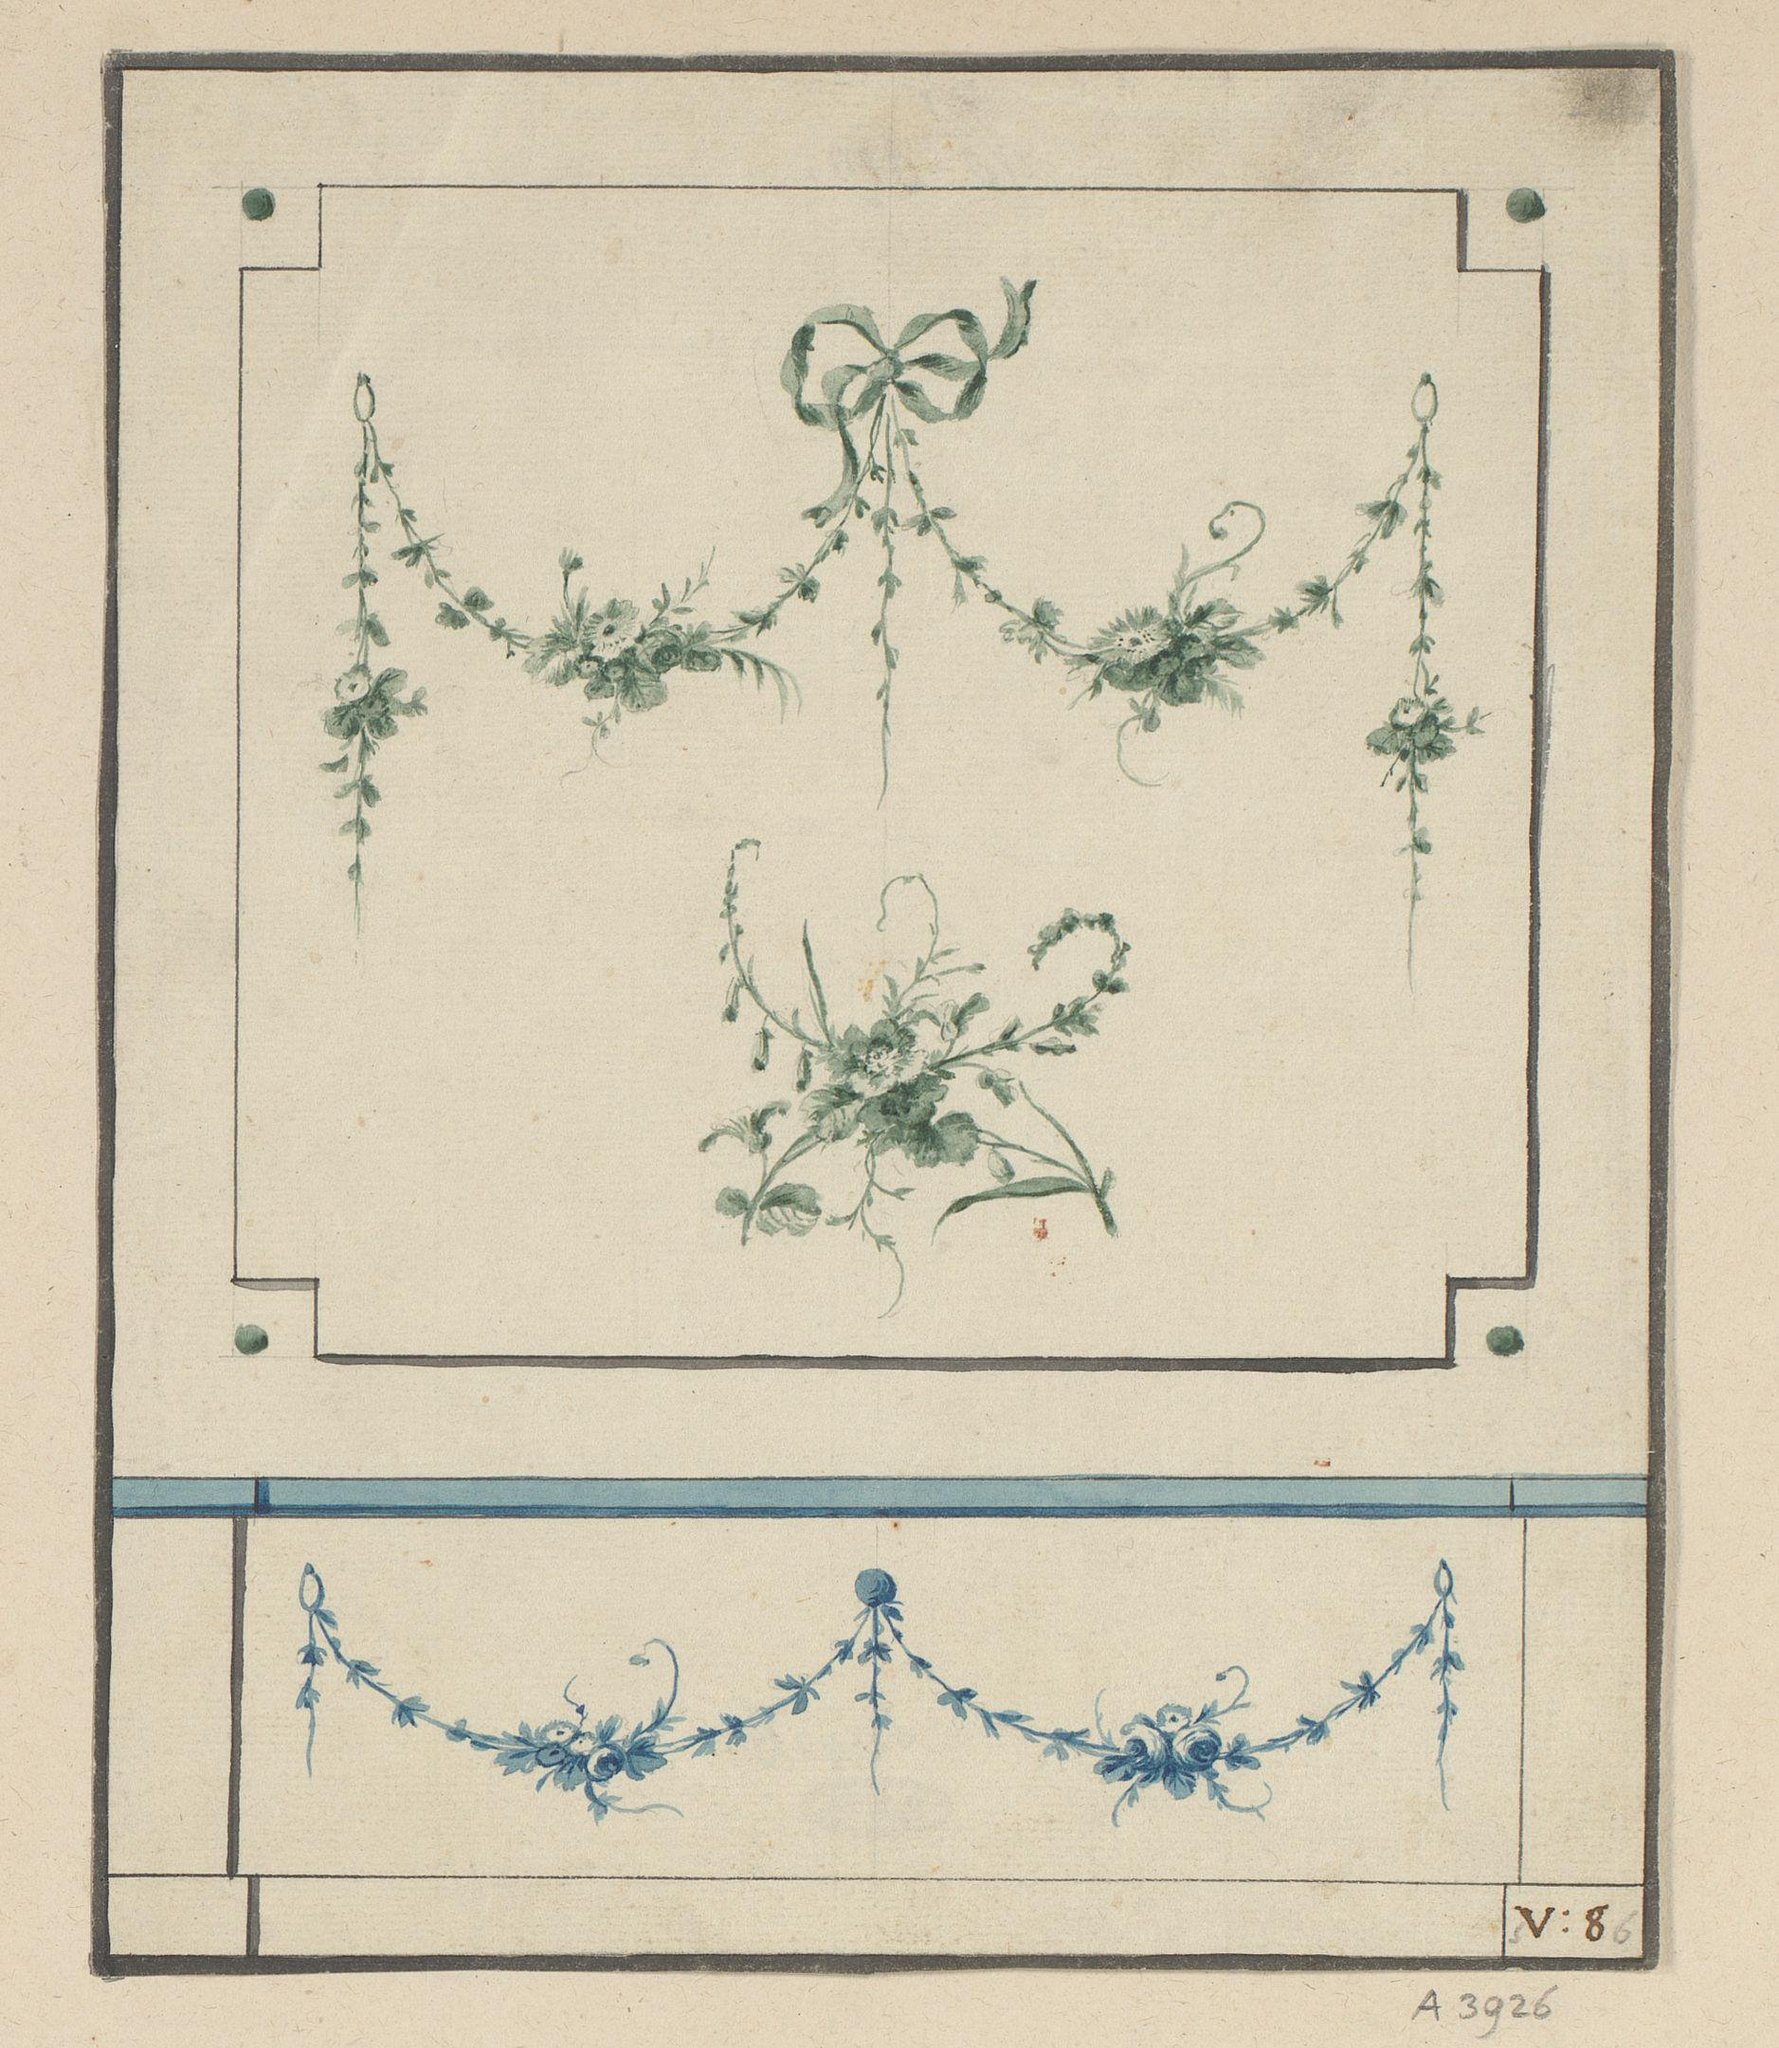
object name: album leaf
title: Ontwerptekening voor een kamerwand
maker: abraham van strij (i)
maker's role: draughtsman, painter, print maker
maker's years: 1753-1826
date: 1763-1826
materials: paint, paper, pencil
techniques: brush, pen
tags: garland, wreath, wall-covering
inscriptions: collector's mark: Lugt 2228, inscription: ‘No. 619.’, inscription: ‘V: 8’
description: De tekeningen van Abraham van Strij zijn op een later moment ingevoegd in het album met tekeningen van Jurriaan Andriessen.